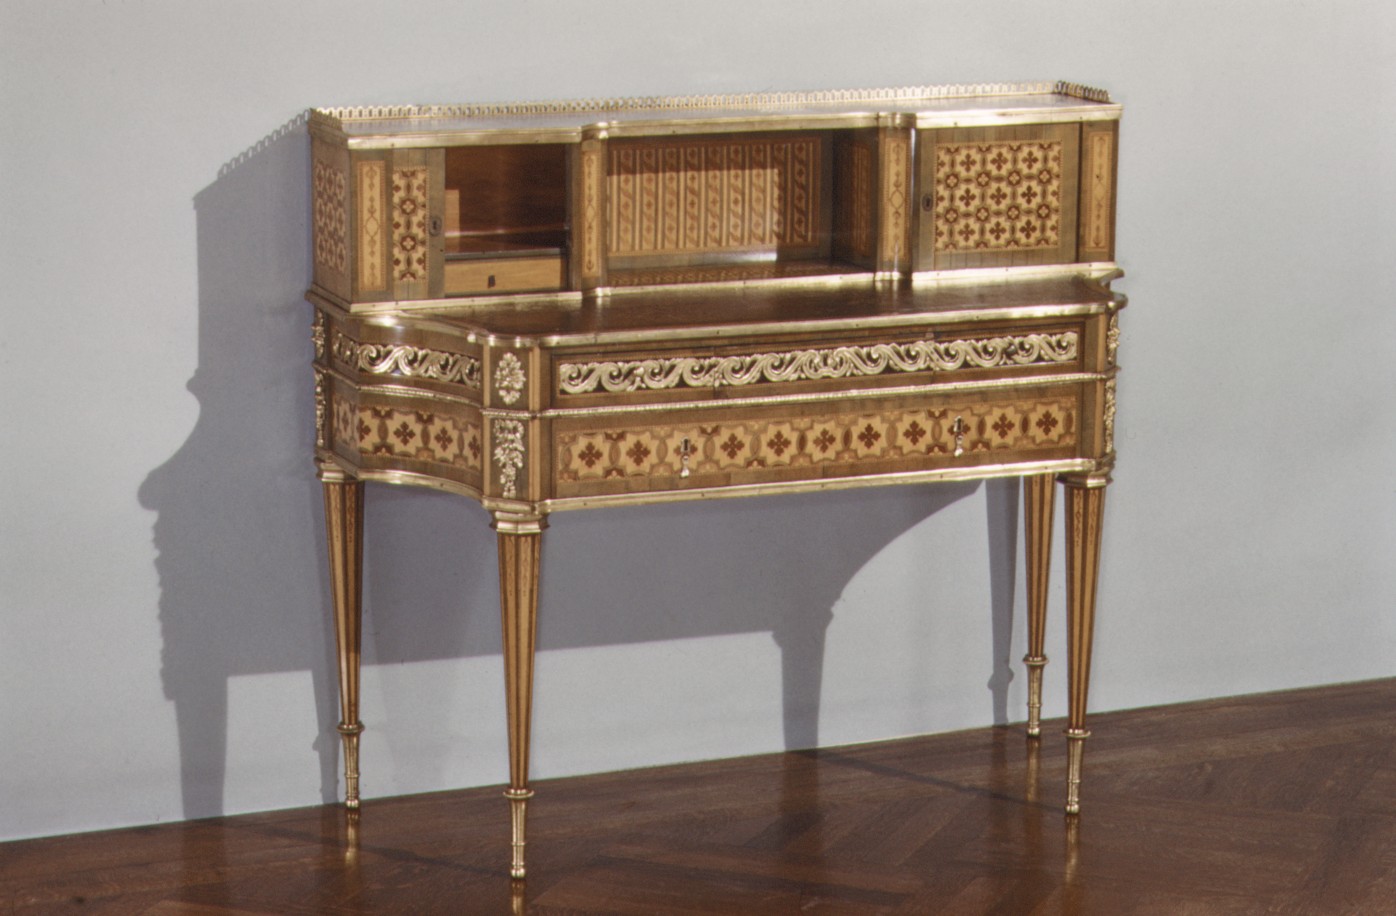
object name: desk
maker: mathieu-guillaume cramer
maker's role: maker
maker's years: 1741-1801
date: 1780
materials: gilt bronze, marble, wood, textile